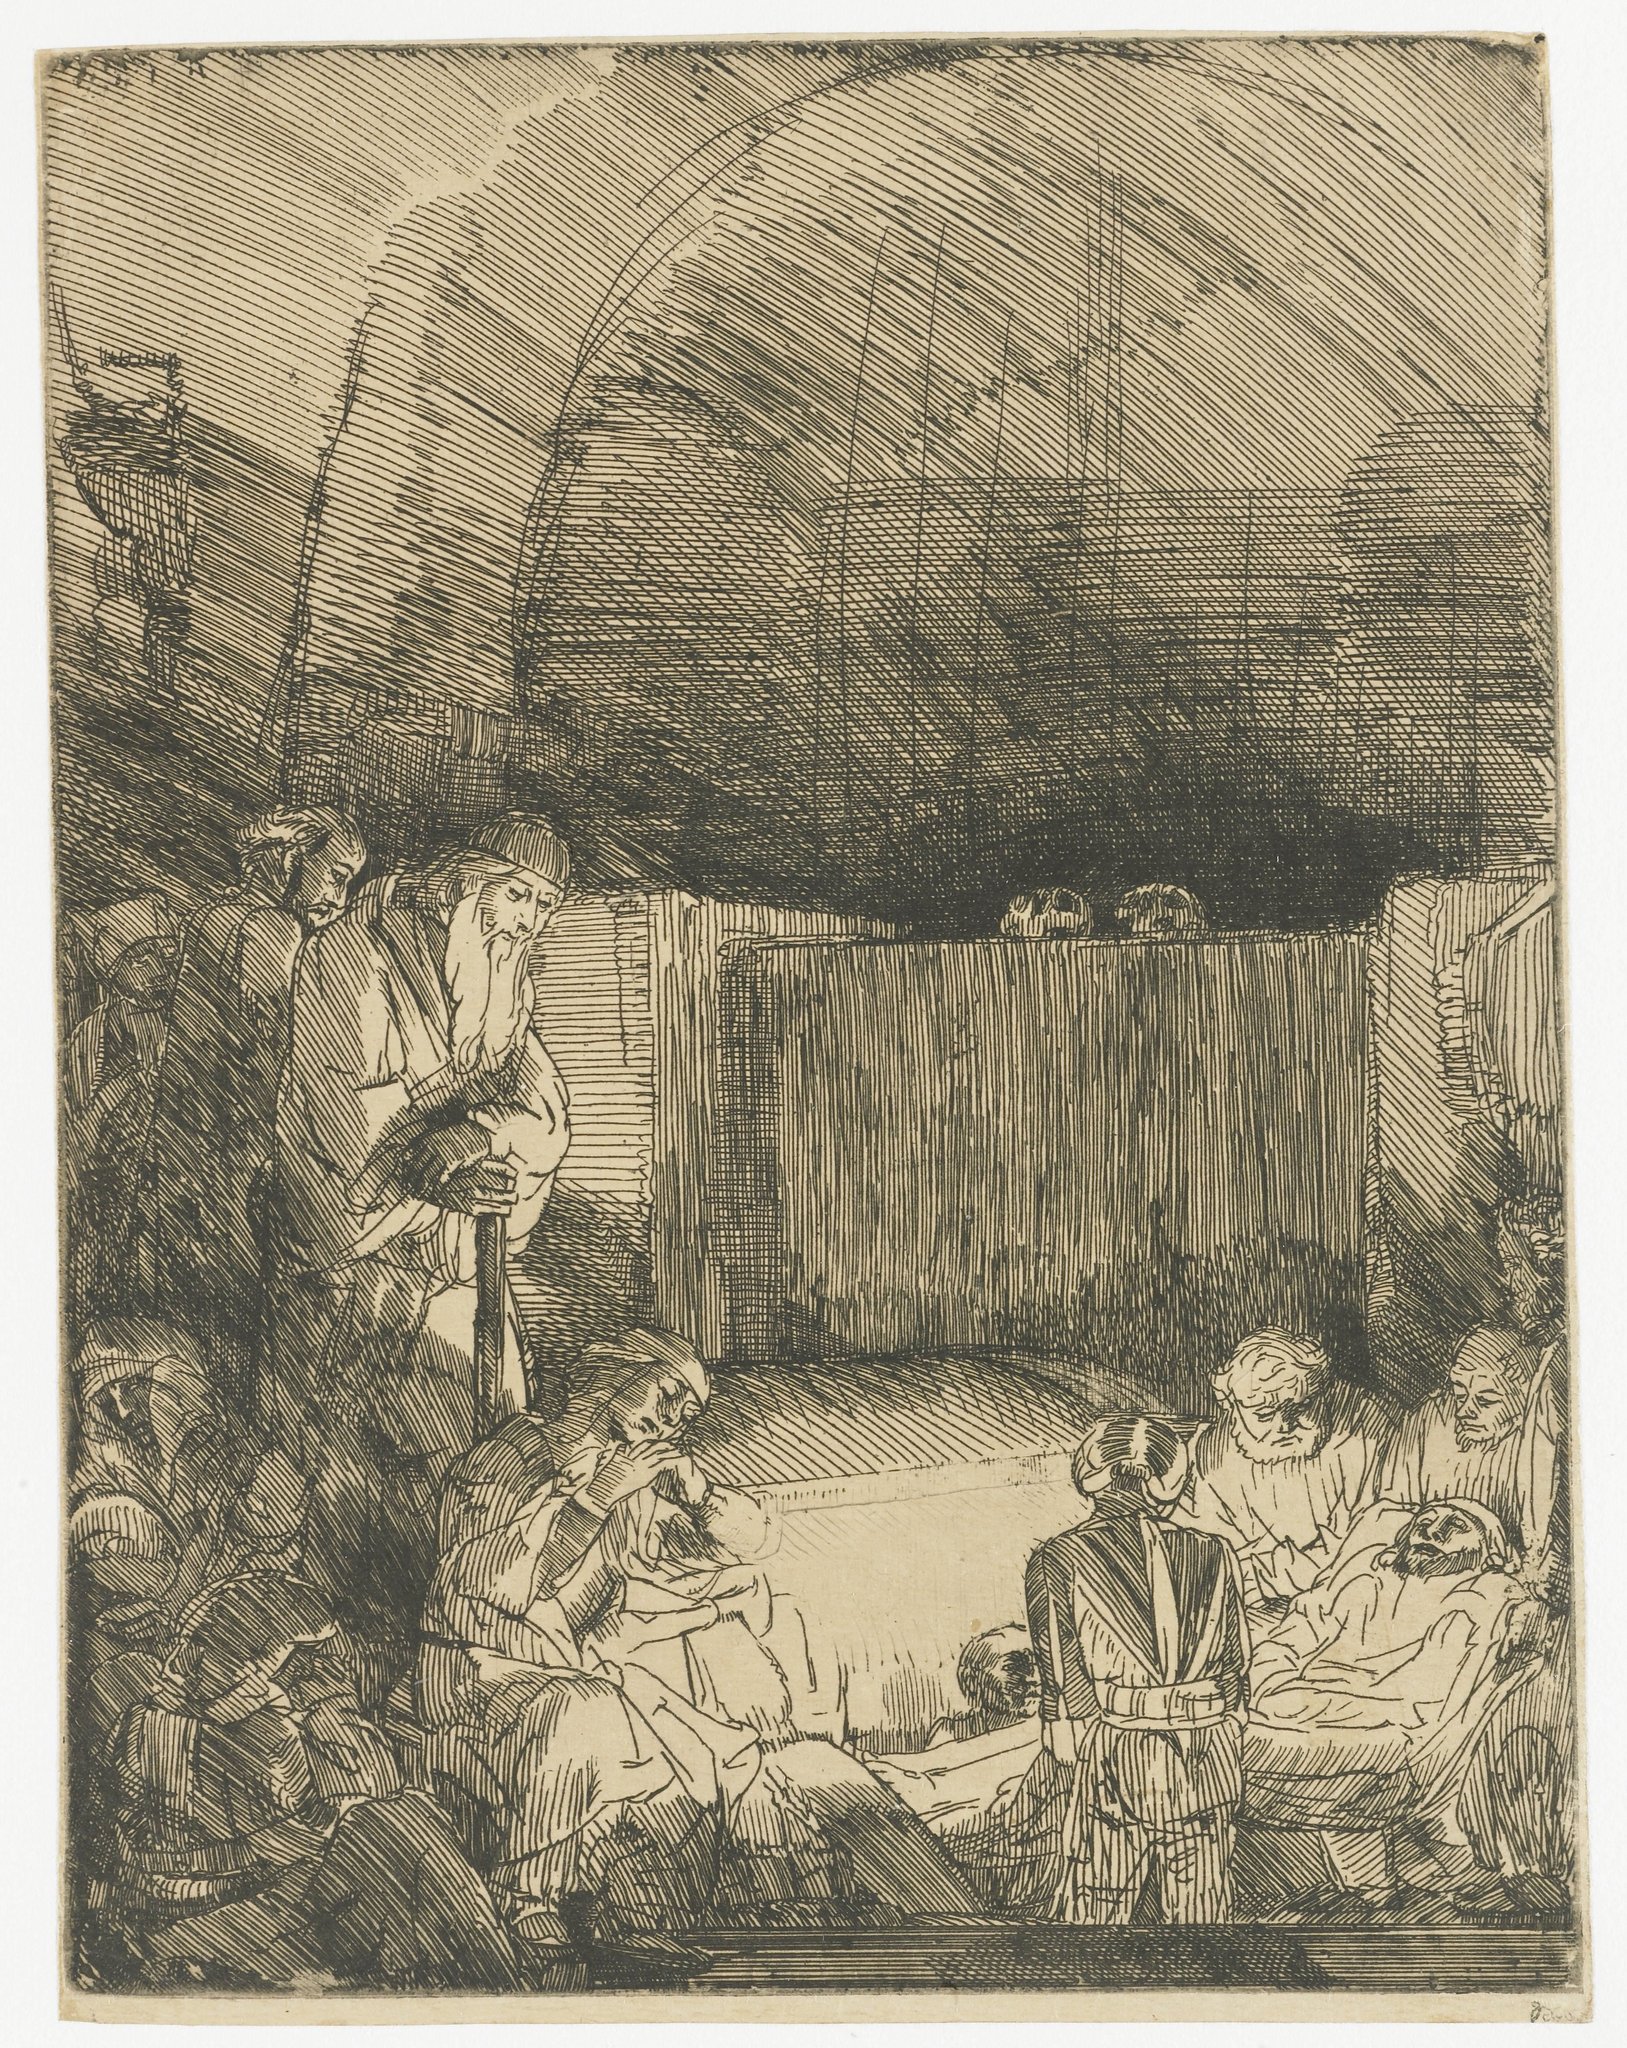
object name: print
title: The Entombment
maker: rembrandt van rijn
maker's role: draughtsman, painter, print maker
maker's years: 1606-1669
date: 1654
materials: paper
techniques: etching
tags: christ's entombment (possibly by angels)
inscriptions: mark: Lugt 2100 b, mark:, mark: Lugt 2849?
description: Christ is being laid in a tomb as mourning bystanders look on. The areas of shadow in the scene consist of powerful parallel lines. The light source is hidden behind the man with his back to us. Barely any hatching can be discerned in that most brightly lit spot. The deep yellow Japanese paper lends the scene a warm glow, which accords well with lamp or torchlight.